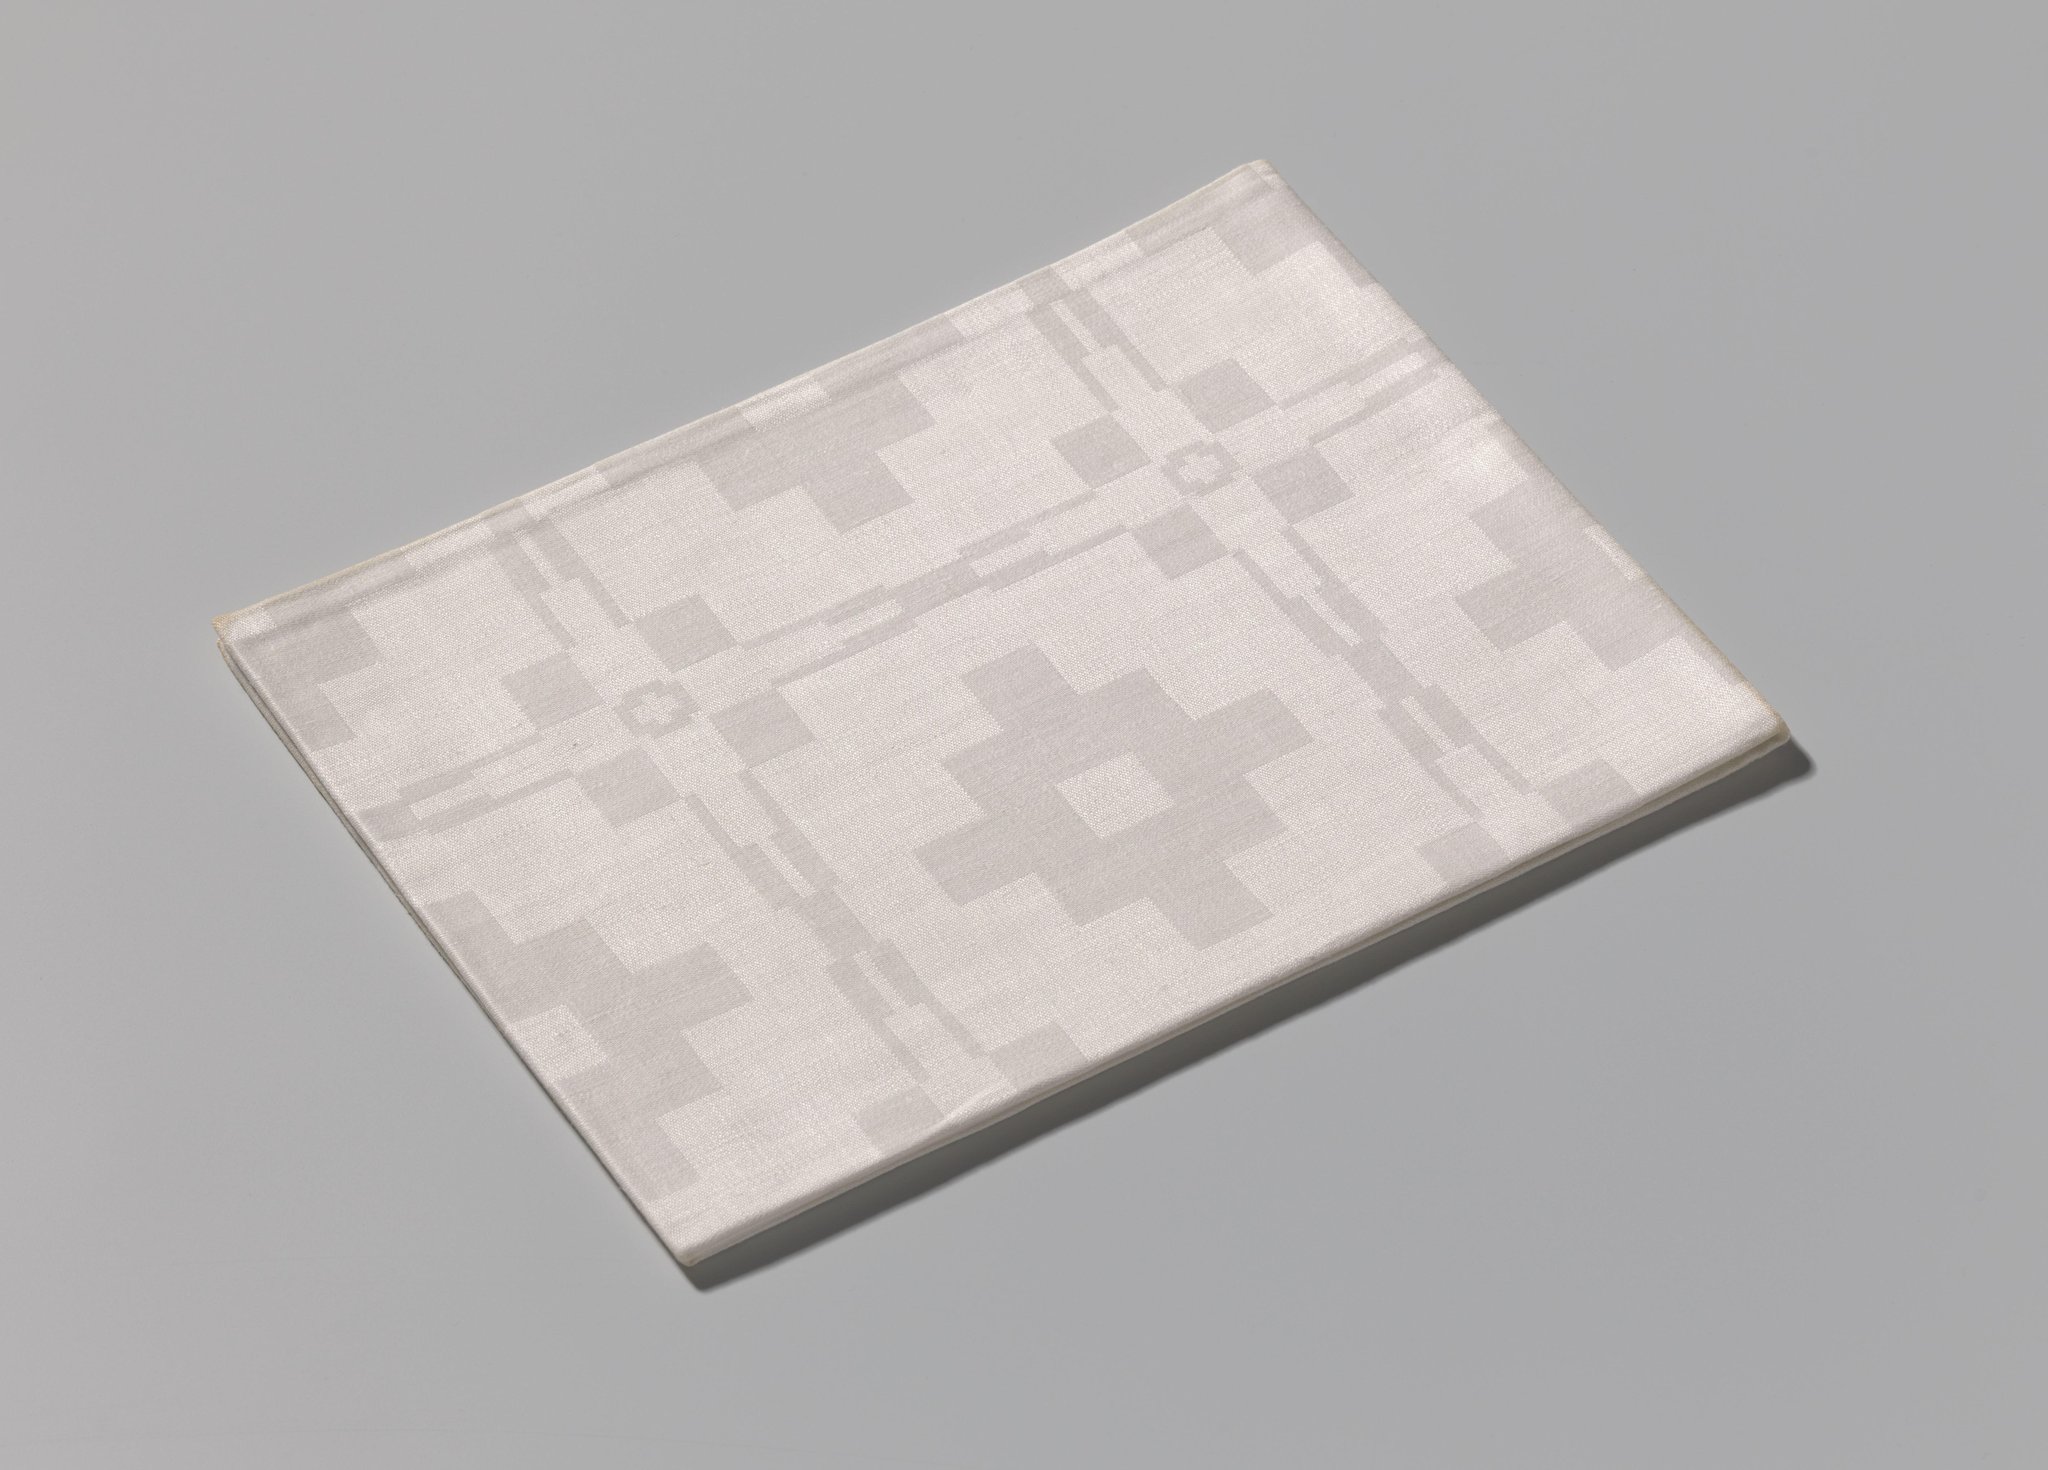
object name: napkin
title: Pellen met patroon 'uitgehouwen steen of hoekster'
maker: Anonymous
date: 1800-1899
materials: linen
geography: netherlands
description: Servet van wit linnen met pellenpatroon 'uitgehouwen steen of hoekster' en randen, merk HR 12.